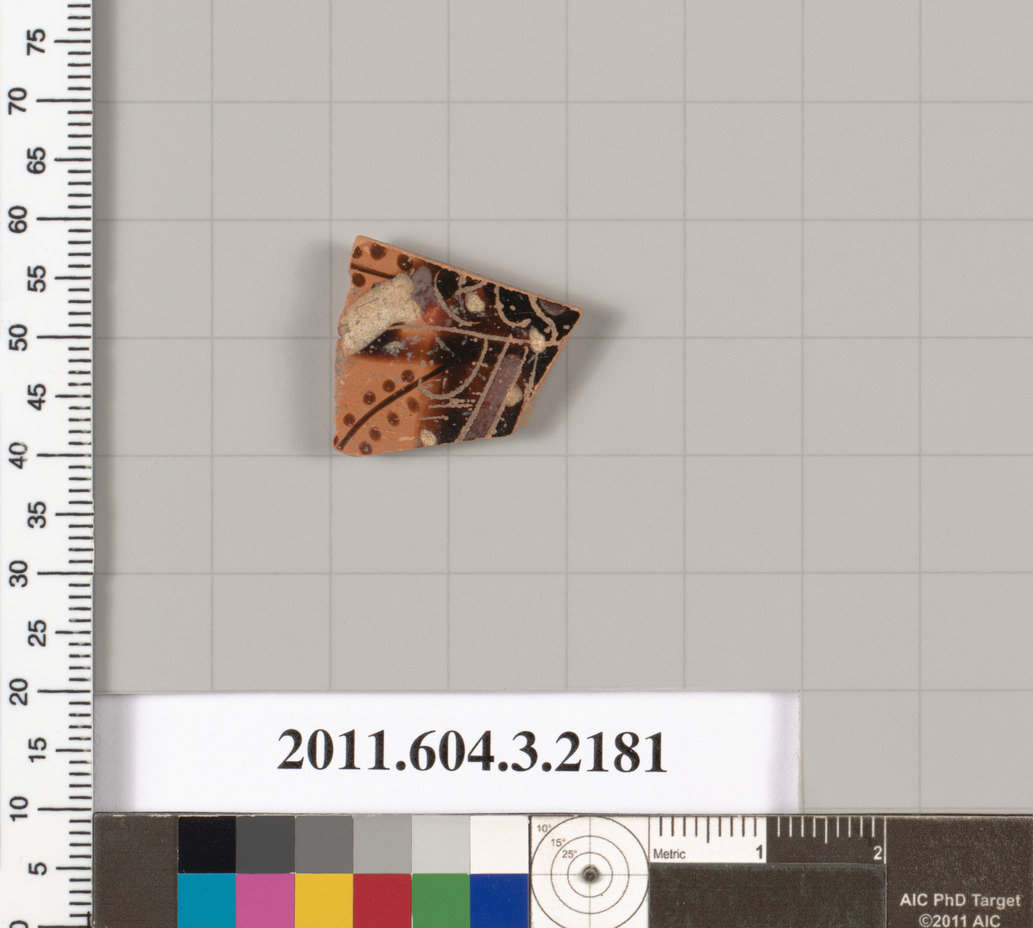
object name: kylix fragment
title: Terracotta fragment of a kylix (drinking cup)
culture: greek, attic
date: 534-501 BCE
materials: terracotta